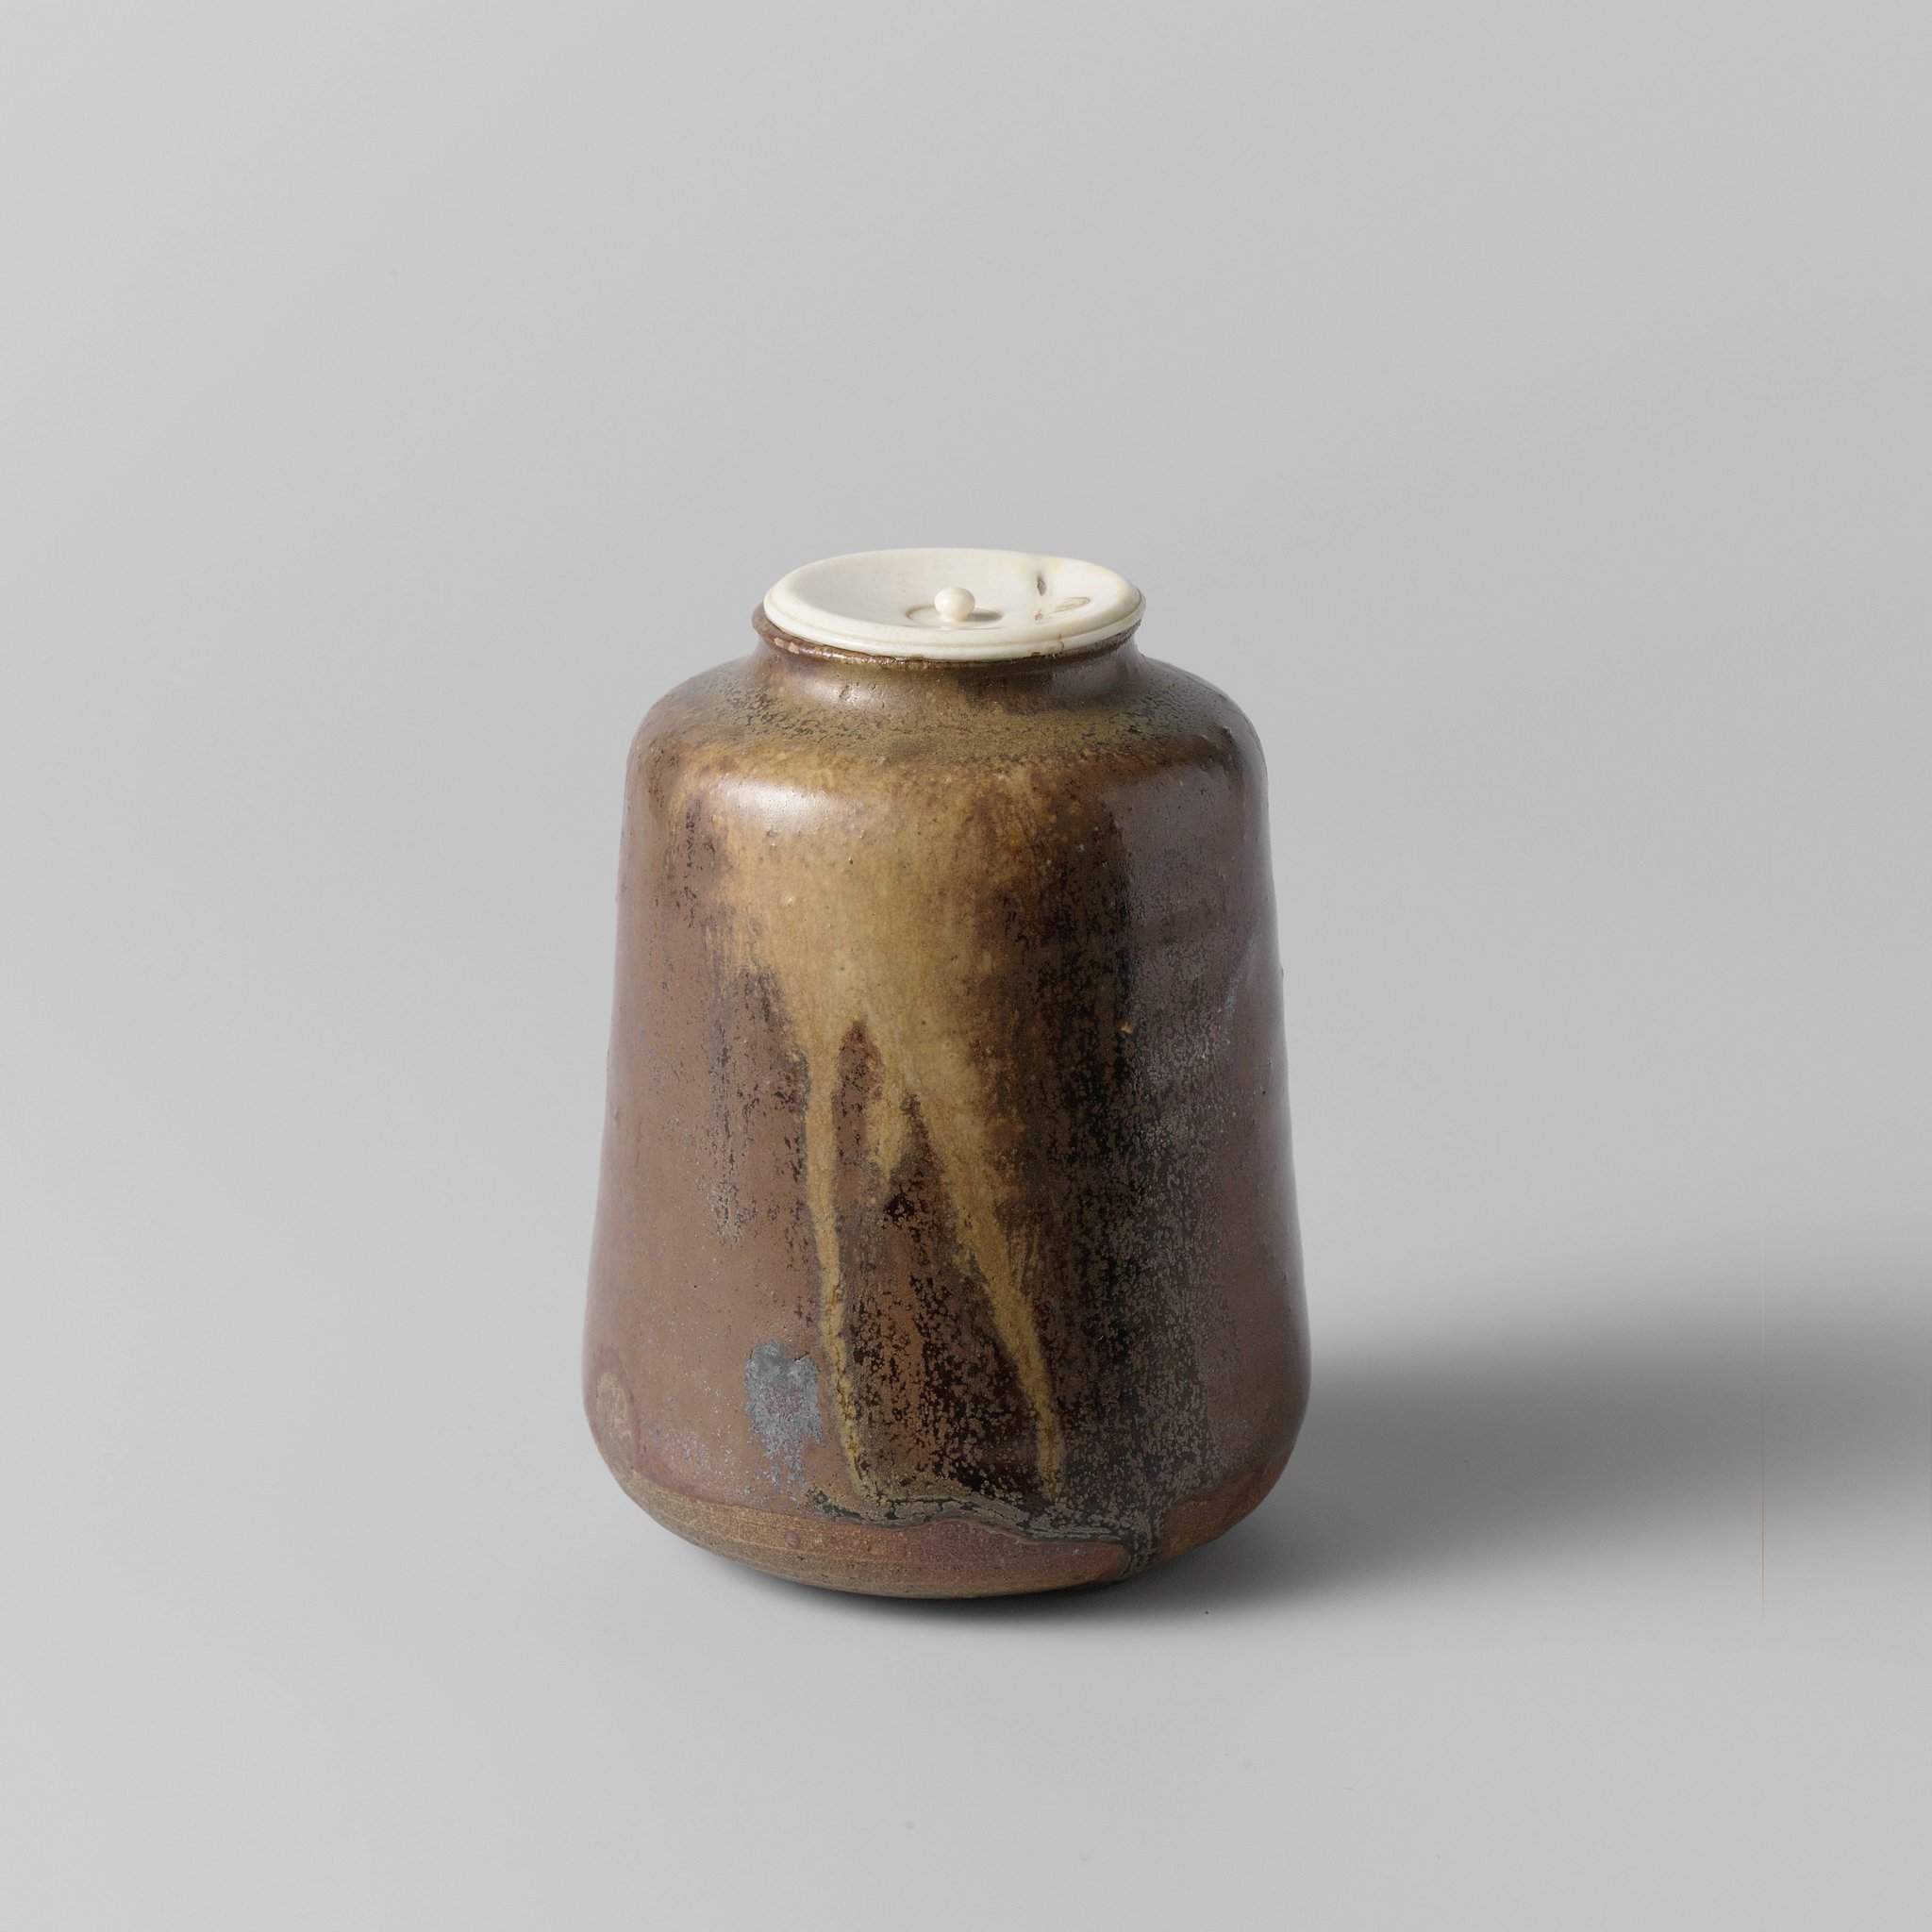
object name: chaire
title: Tea caddy with a goldenbrown glaze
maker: Anonymous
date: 1400-1950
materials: glaze, ivory, stoneware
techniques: firing, turning, vitrification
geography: seto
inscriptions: label: ‘W632’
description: Stoftheebus of chaire van steengoed met een ivoren deksel, gedeeltelijk bedekt met een goudbruin glazuur. Het onderste deel van de bus is ongeglazuurd. Oud label op de onderzijde met 'W632'. Seto in de stijl van Hafugama.